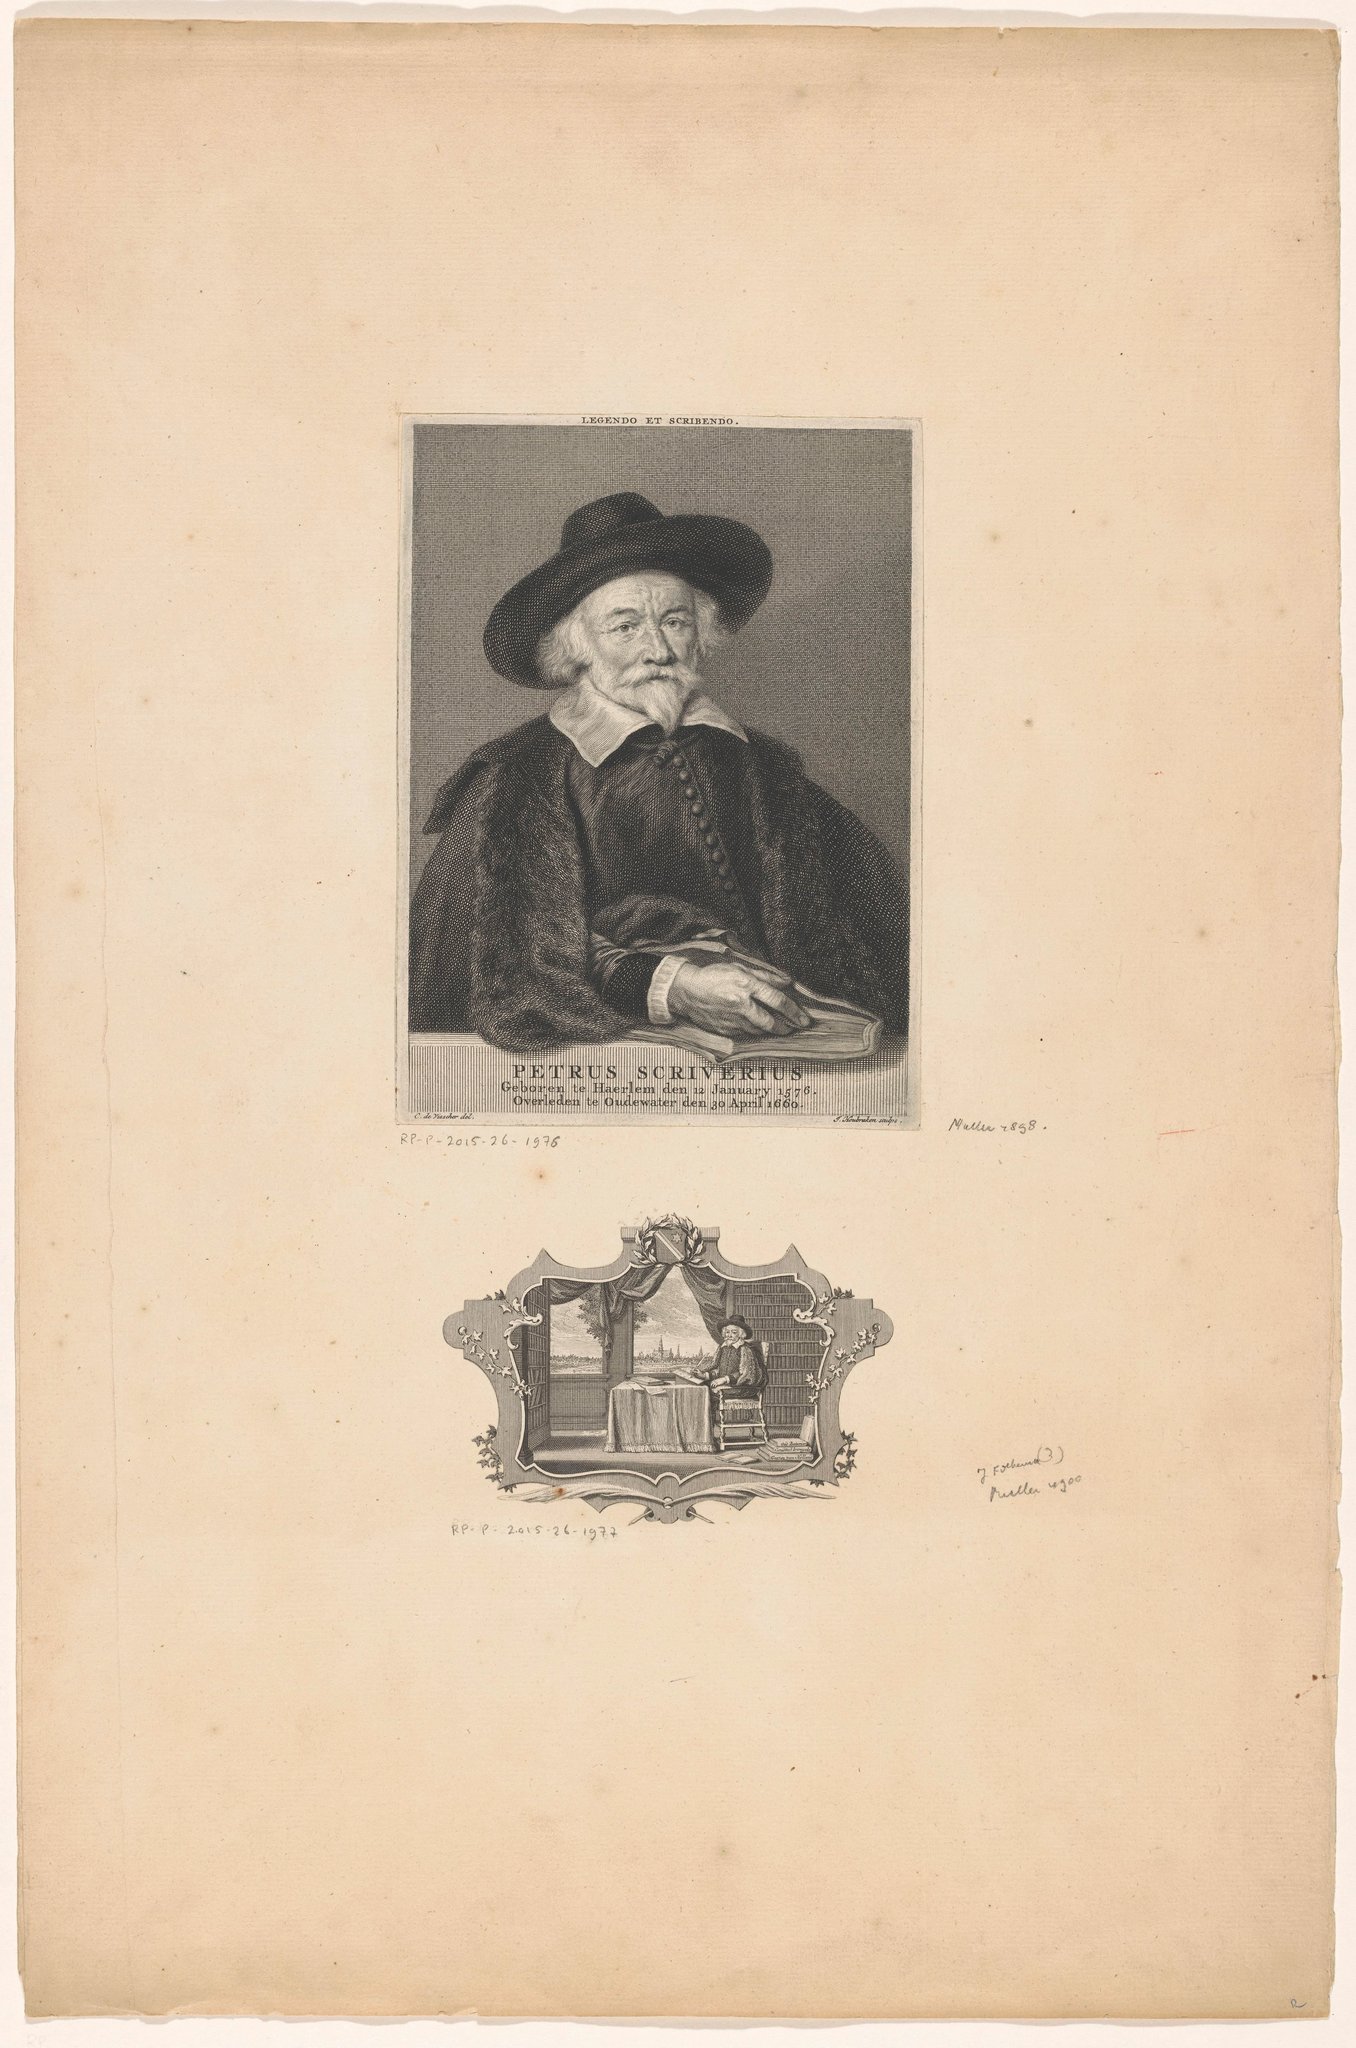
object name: print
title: Portret van Petrus Scriverius achter een schrijftafel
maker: jacob folkema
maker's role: draughtsman, print maker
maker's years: 1692-1767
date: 1702-1767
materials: paper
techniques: etching, snipping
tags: petrus scriverius, writing-table, writing-desk, bookshelves, book, haarlem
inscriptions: collector's mark: Lugt 2228, collector's mark: Lugt 4779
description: Achter de auteur een boekenkast. Op de grond liggen drie door Scriverius geschreven werken. In de achtergrond een gezicht op Haarlem. In een omlijsting met twee ganzenveren en het wapen van Haarlem.